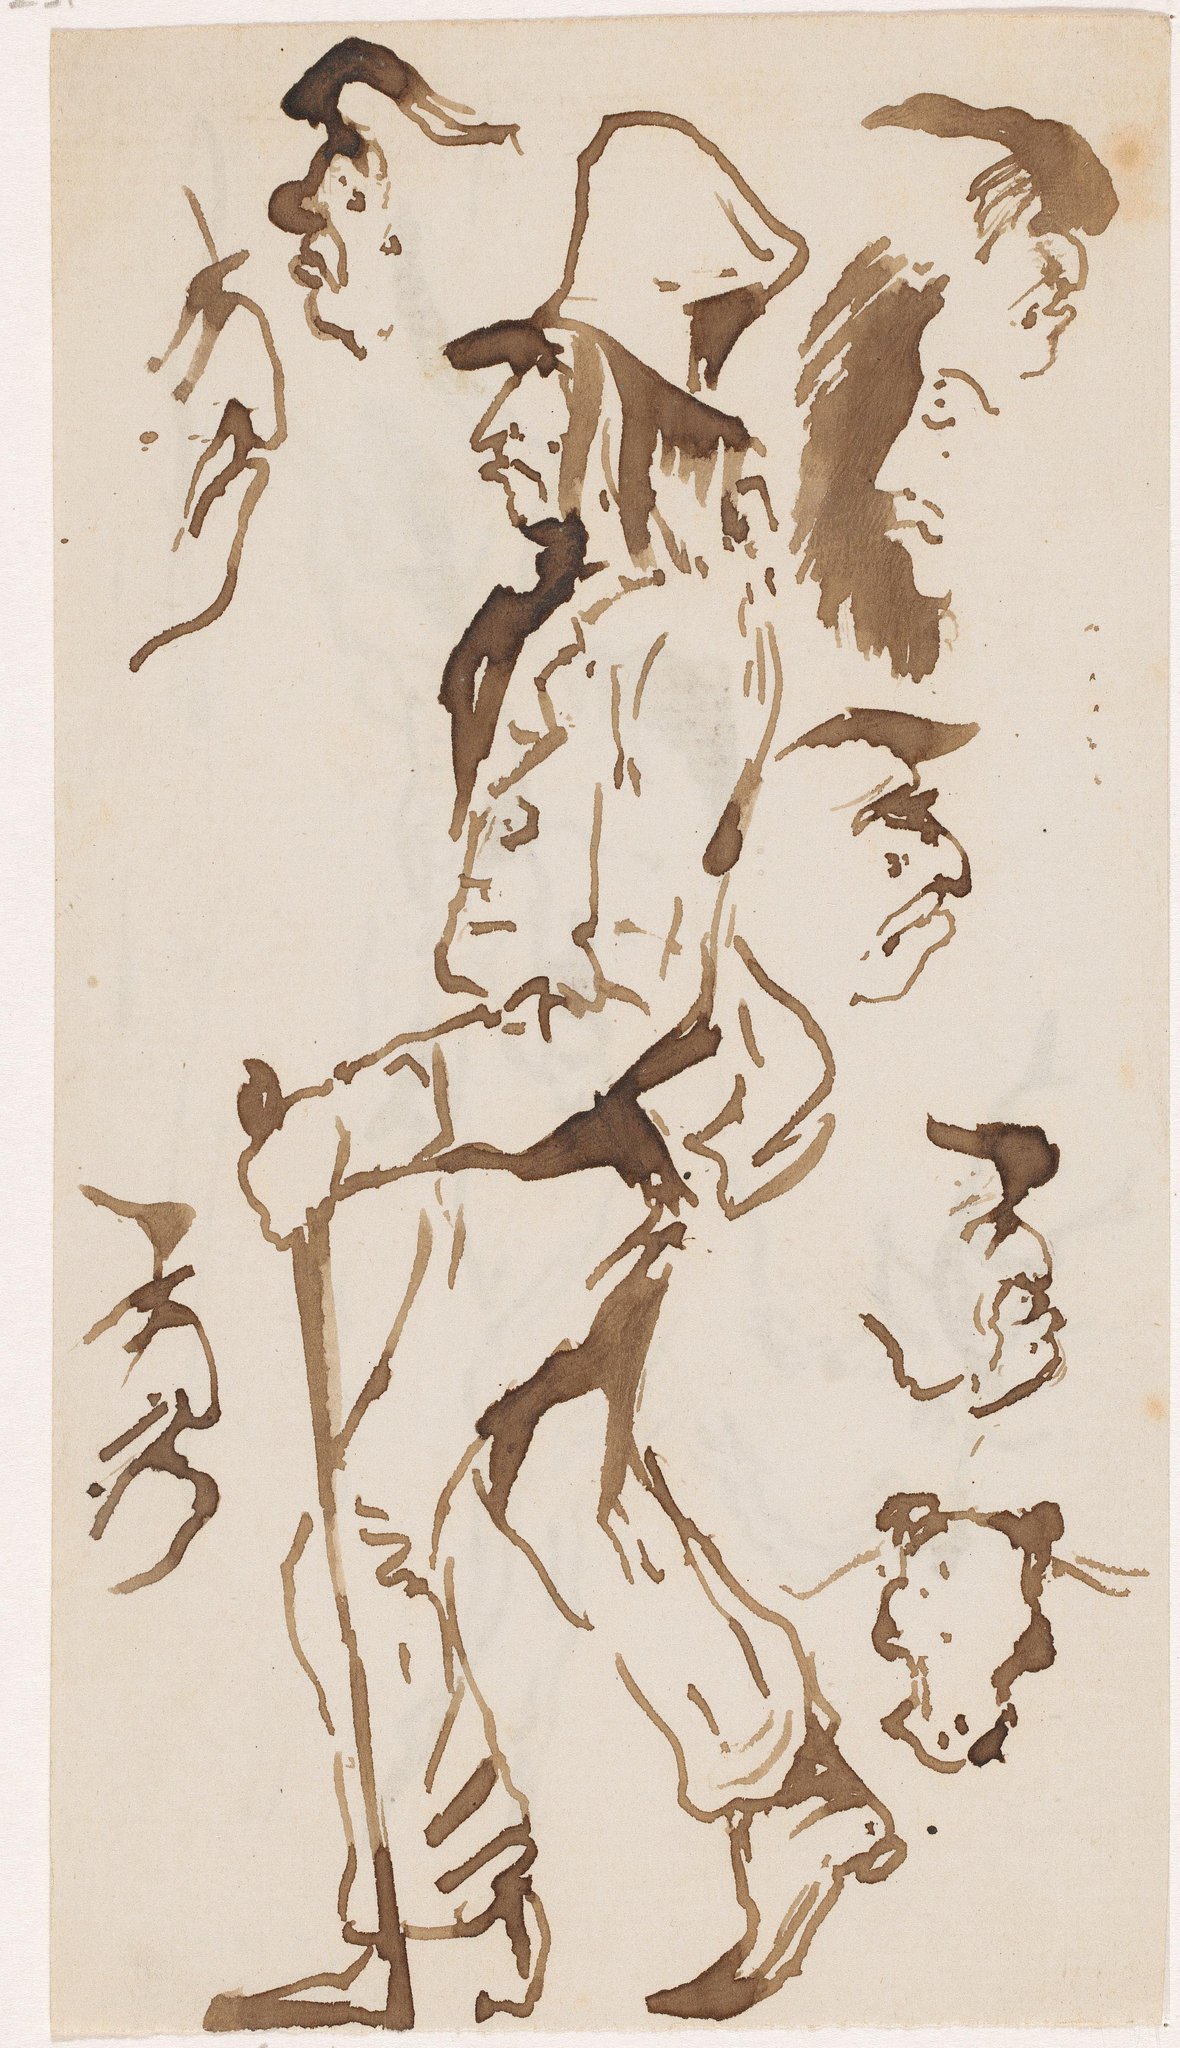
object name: drawing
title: Lopende man en koppen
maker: johannes tavenraat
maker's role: draughtsman, painter, print maker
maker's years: 1809-1881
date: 1840-1880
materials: ink, paper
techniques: pen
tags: standing figure, caricatures (human types)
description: Schetsen van een lopende man met hoge hoed en stok en karikaturale koppen.